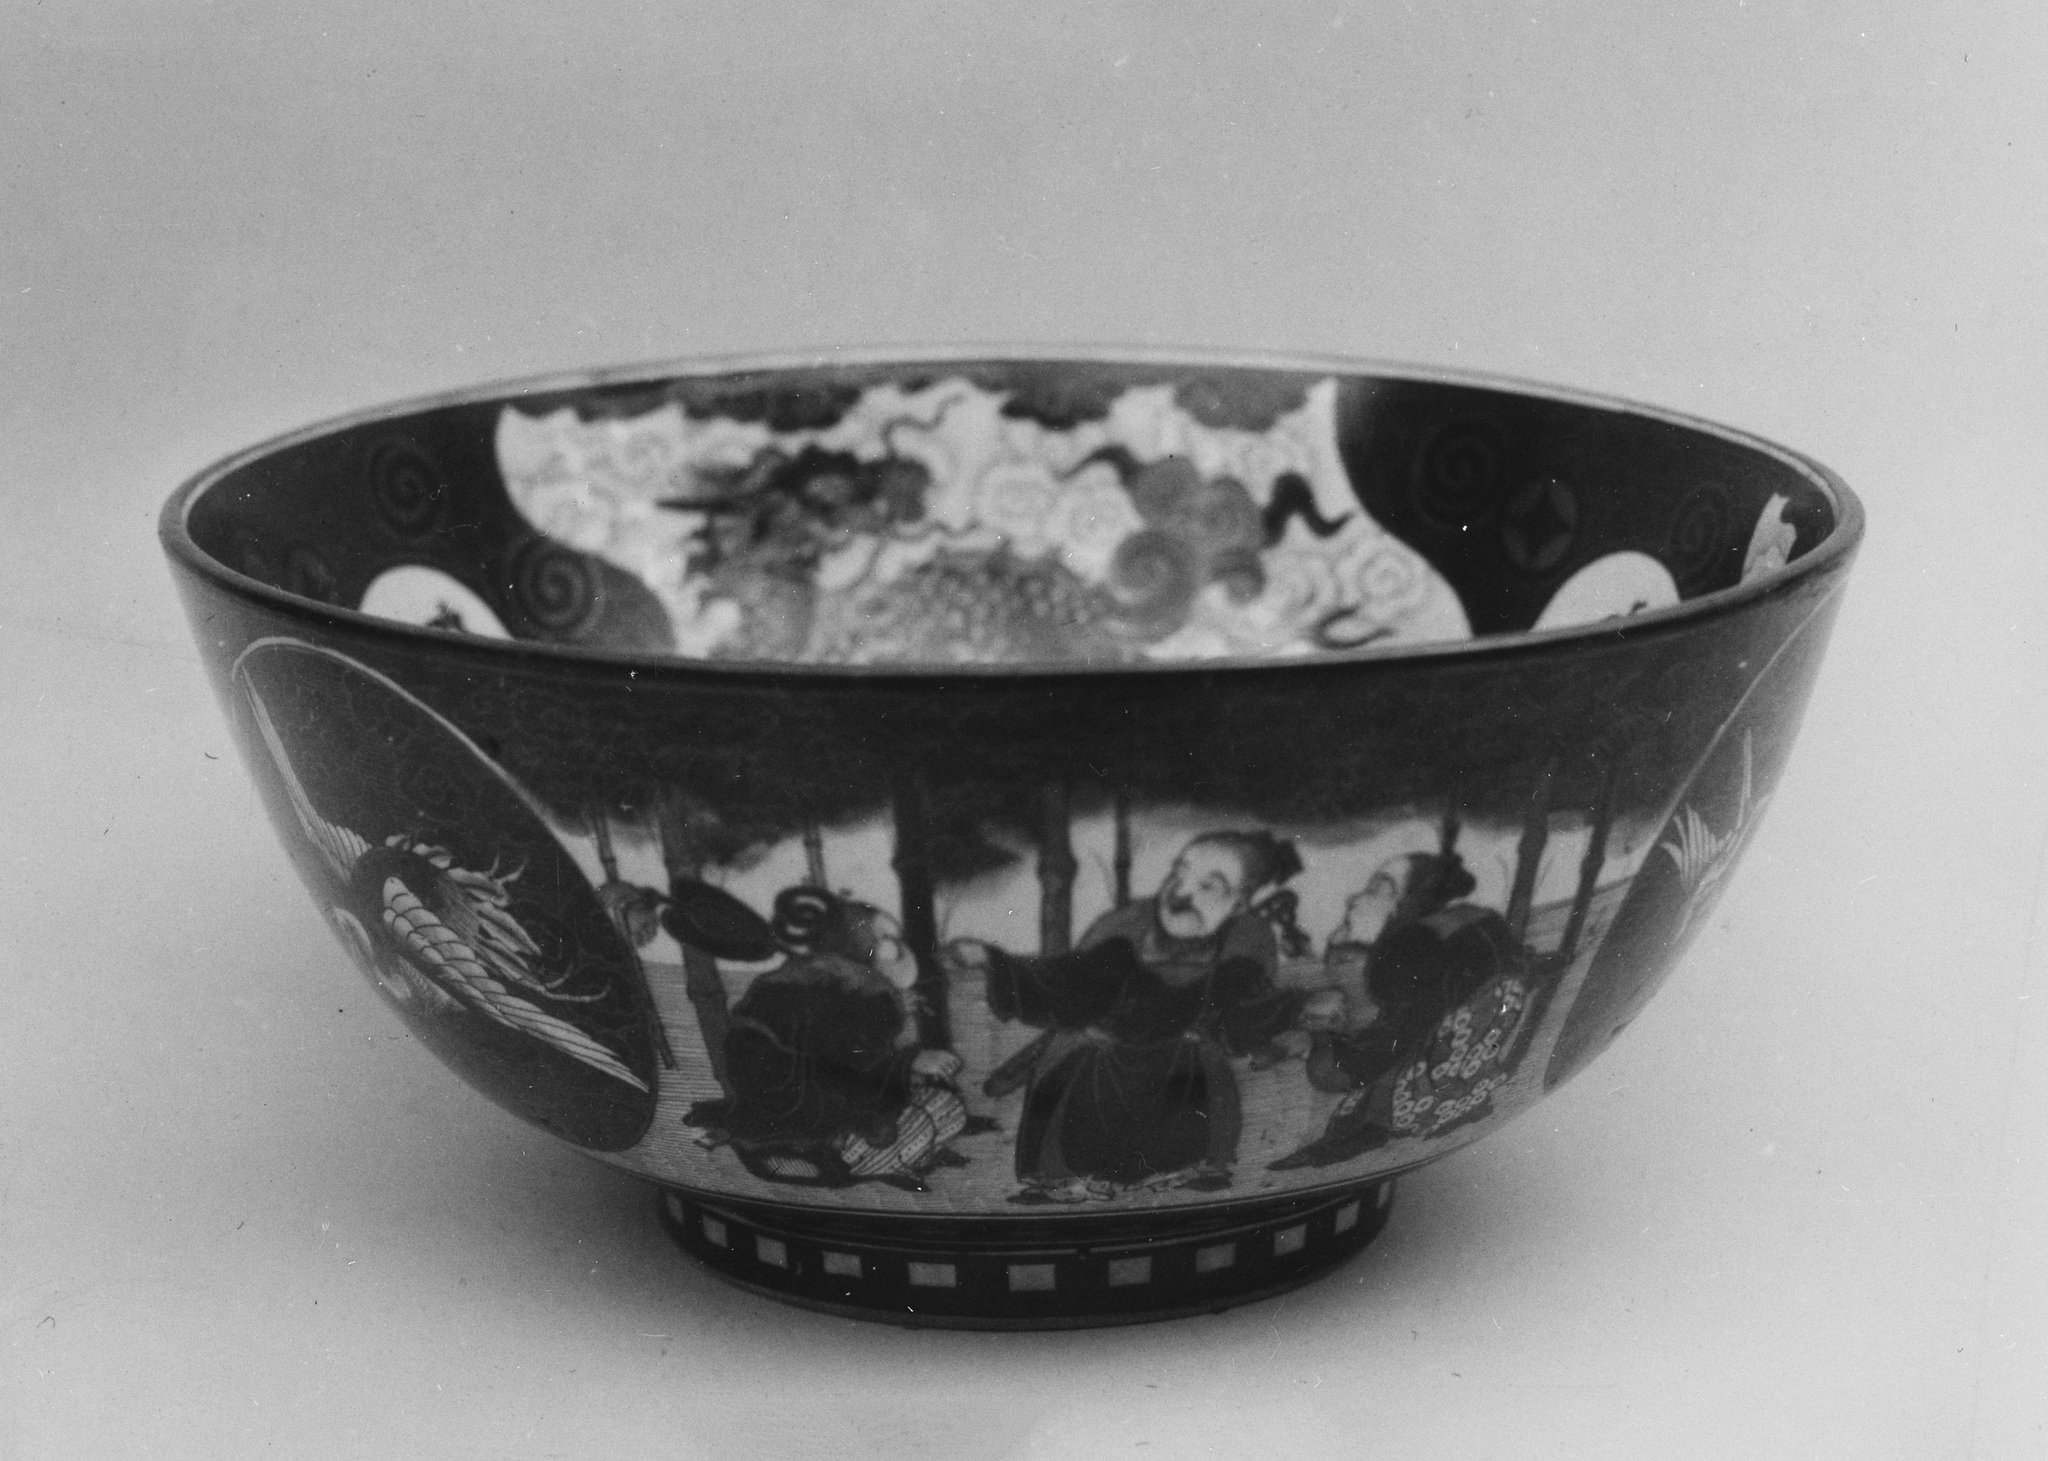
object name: bowl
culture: japanese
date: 1840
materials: gold, porcelain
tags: men,dragons